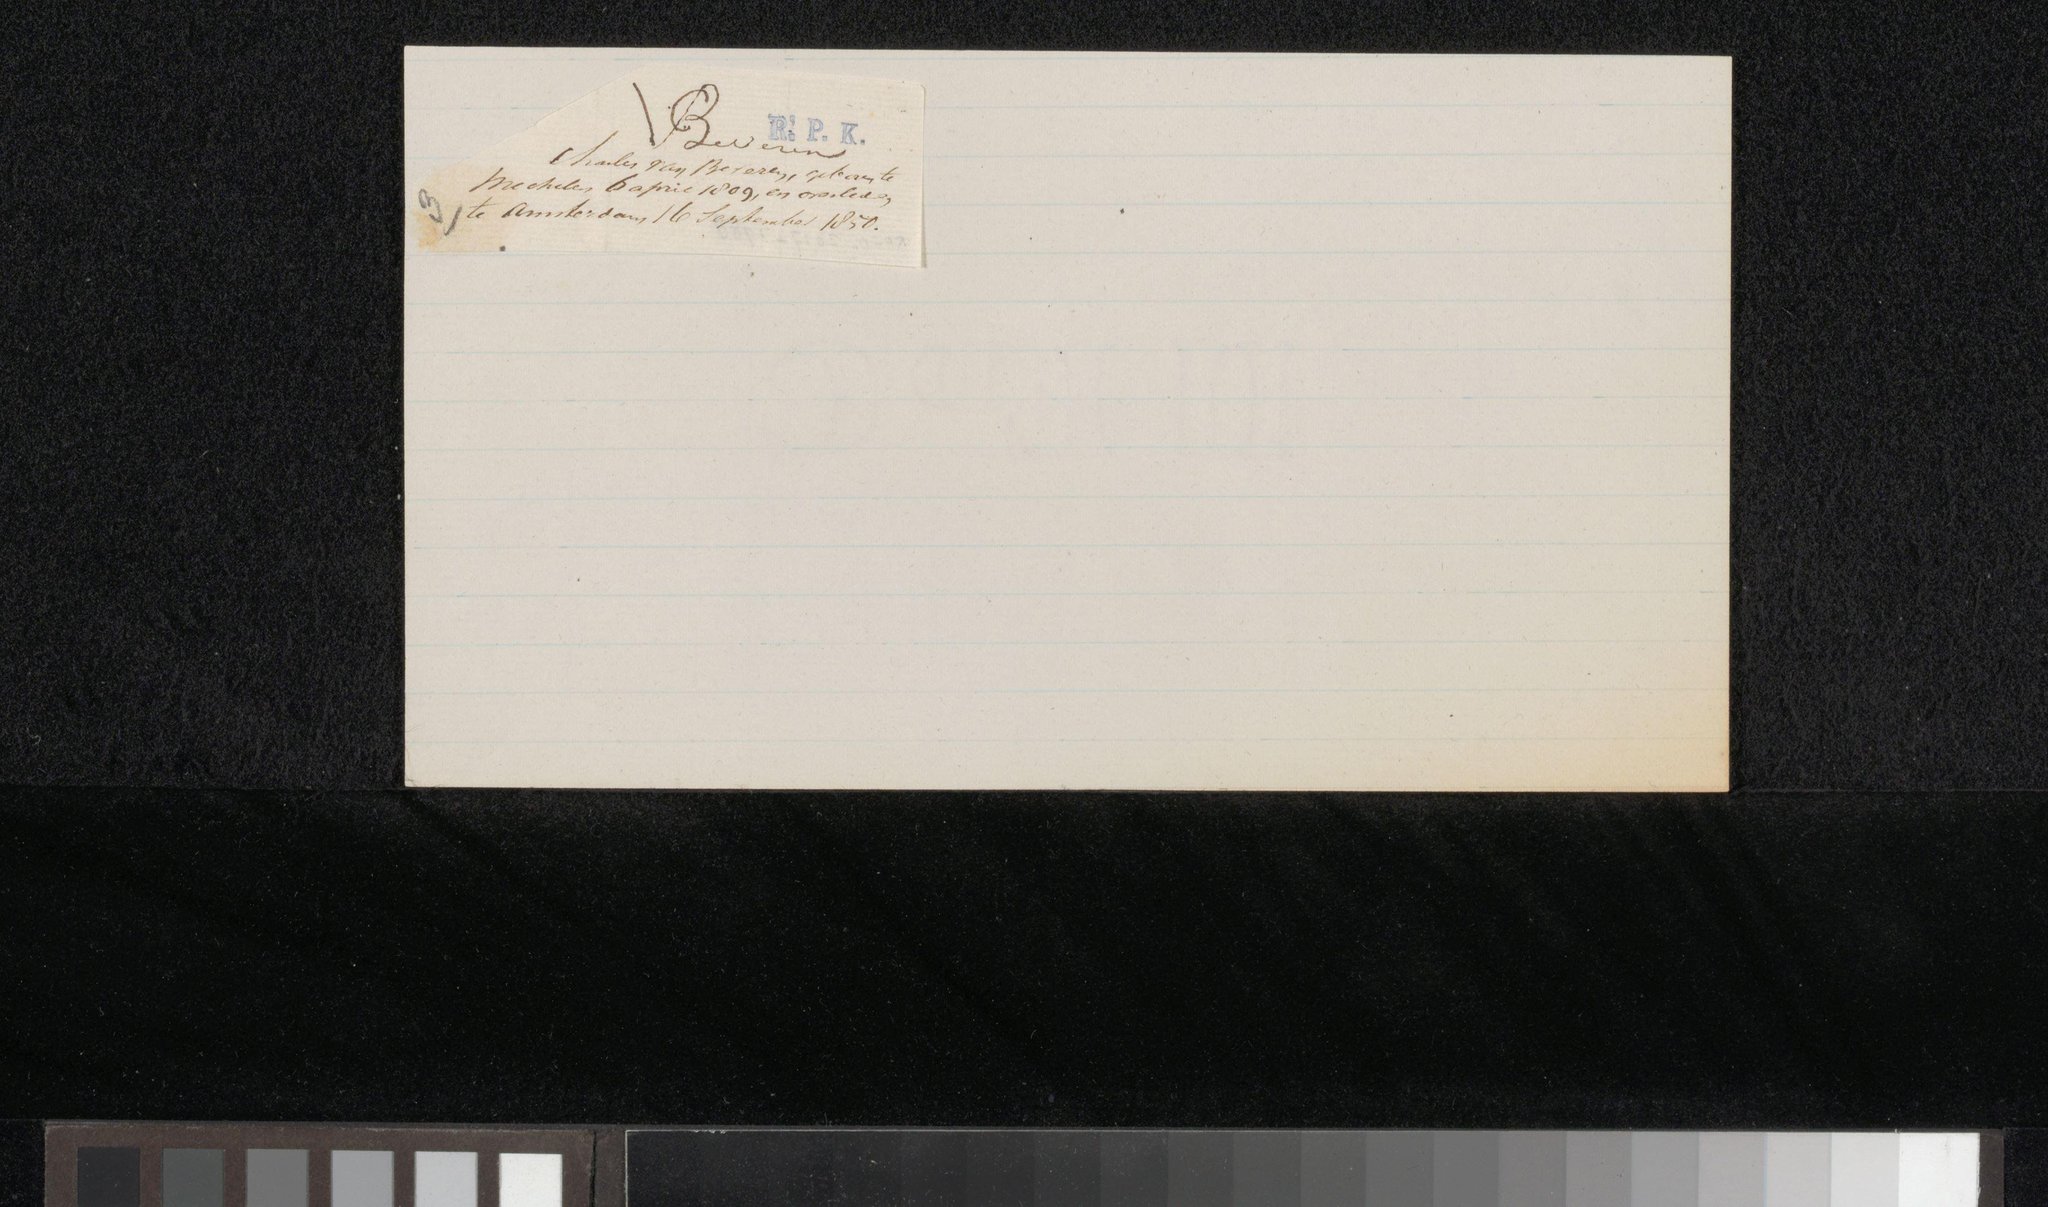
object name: document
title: Document betreffende Charles van Beveren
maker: Anonymous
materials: ink, paper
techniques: pen, writing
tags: mechelen, amsterdam, painter, charles van beveren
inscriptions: collector's mark: Lugt 2233